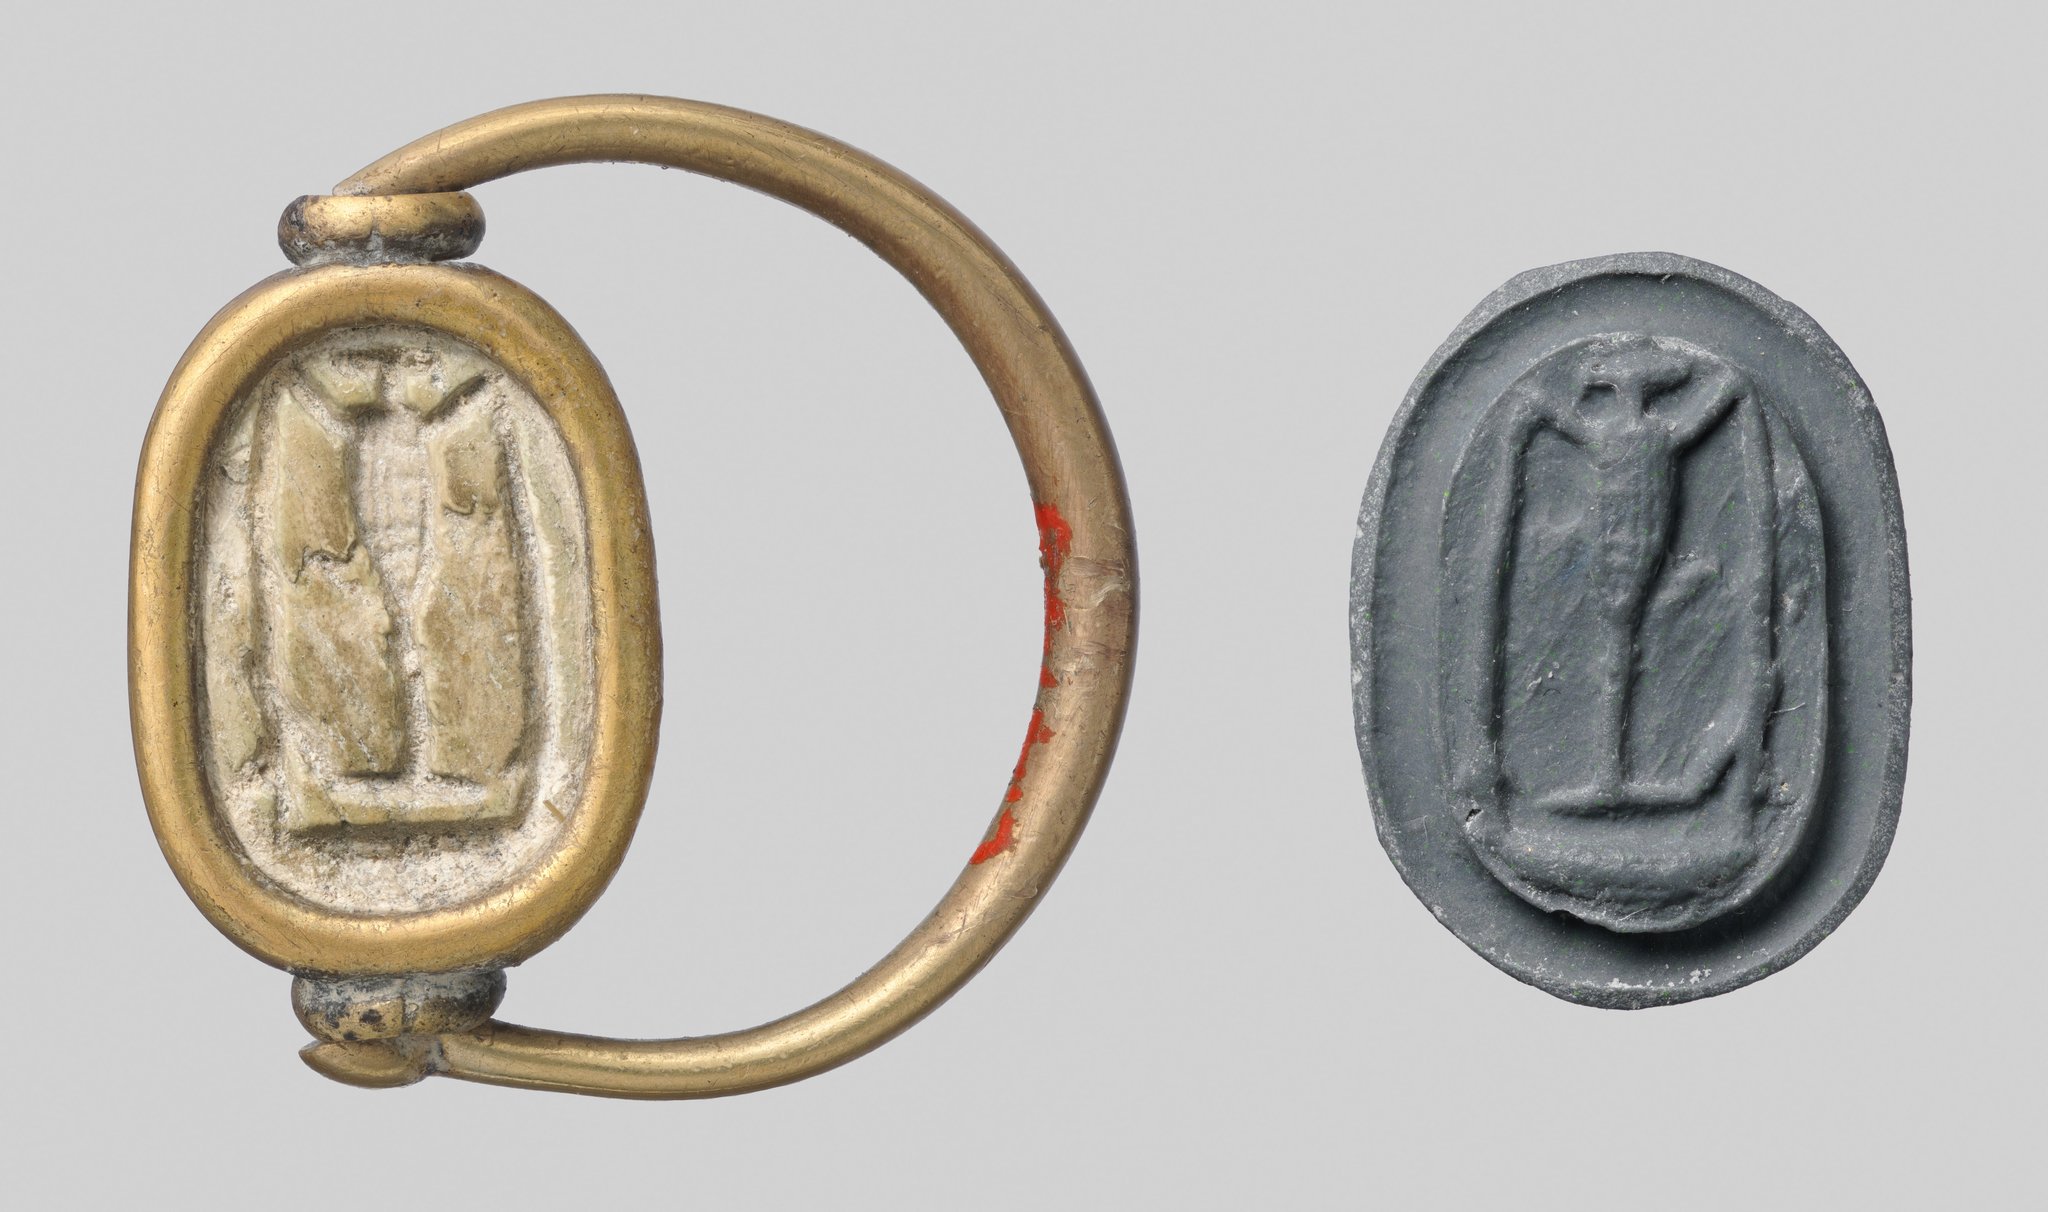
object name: ring with scarab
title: Gold ring with glass scarab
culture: egyptian or phoenician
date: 664-334 BCE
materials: glass, gold, paste